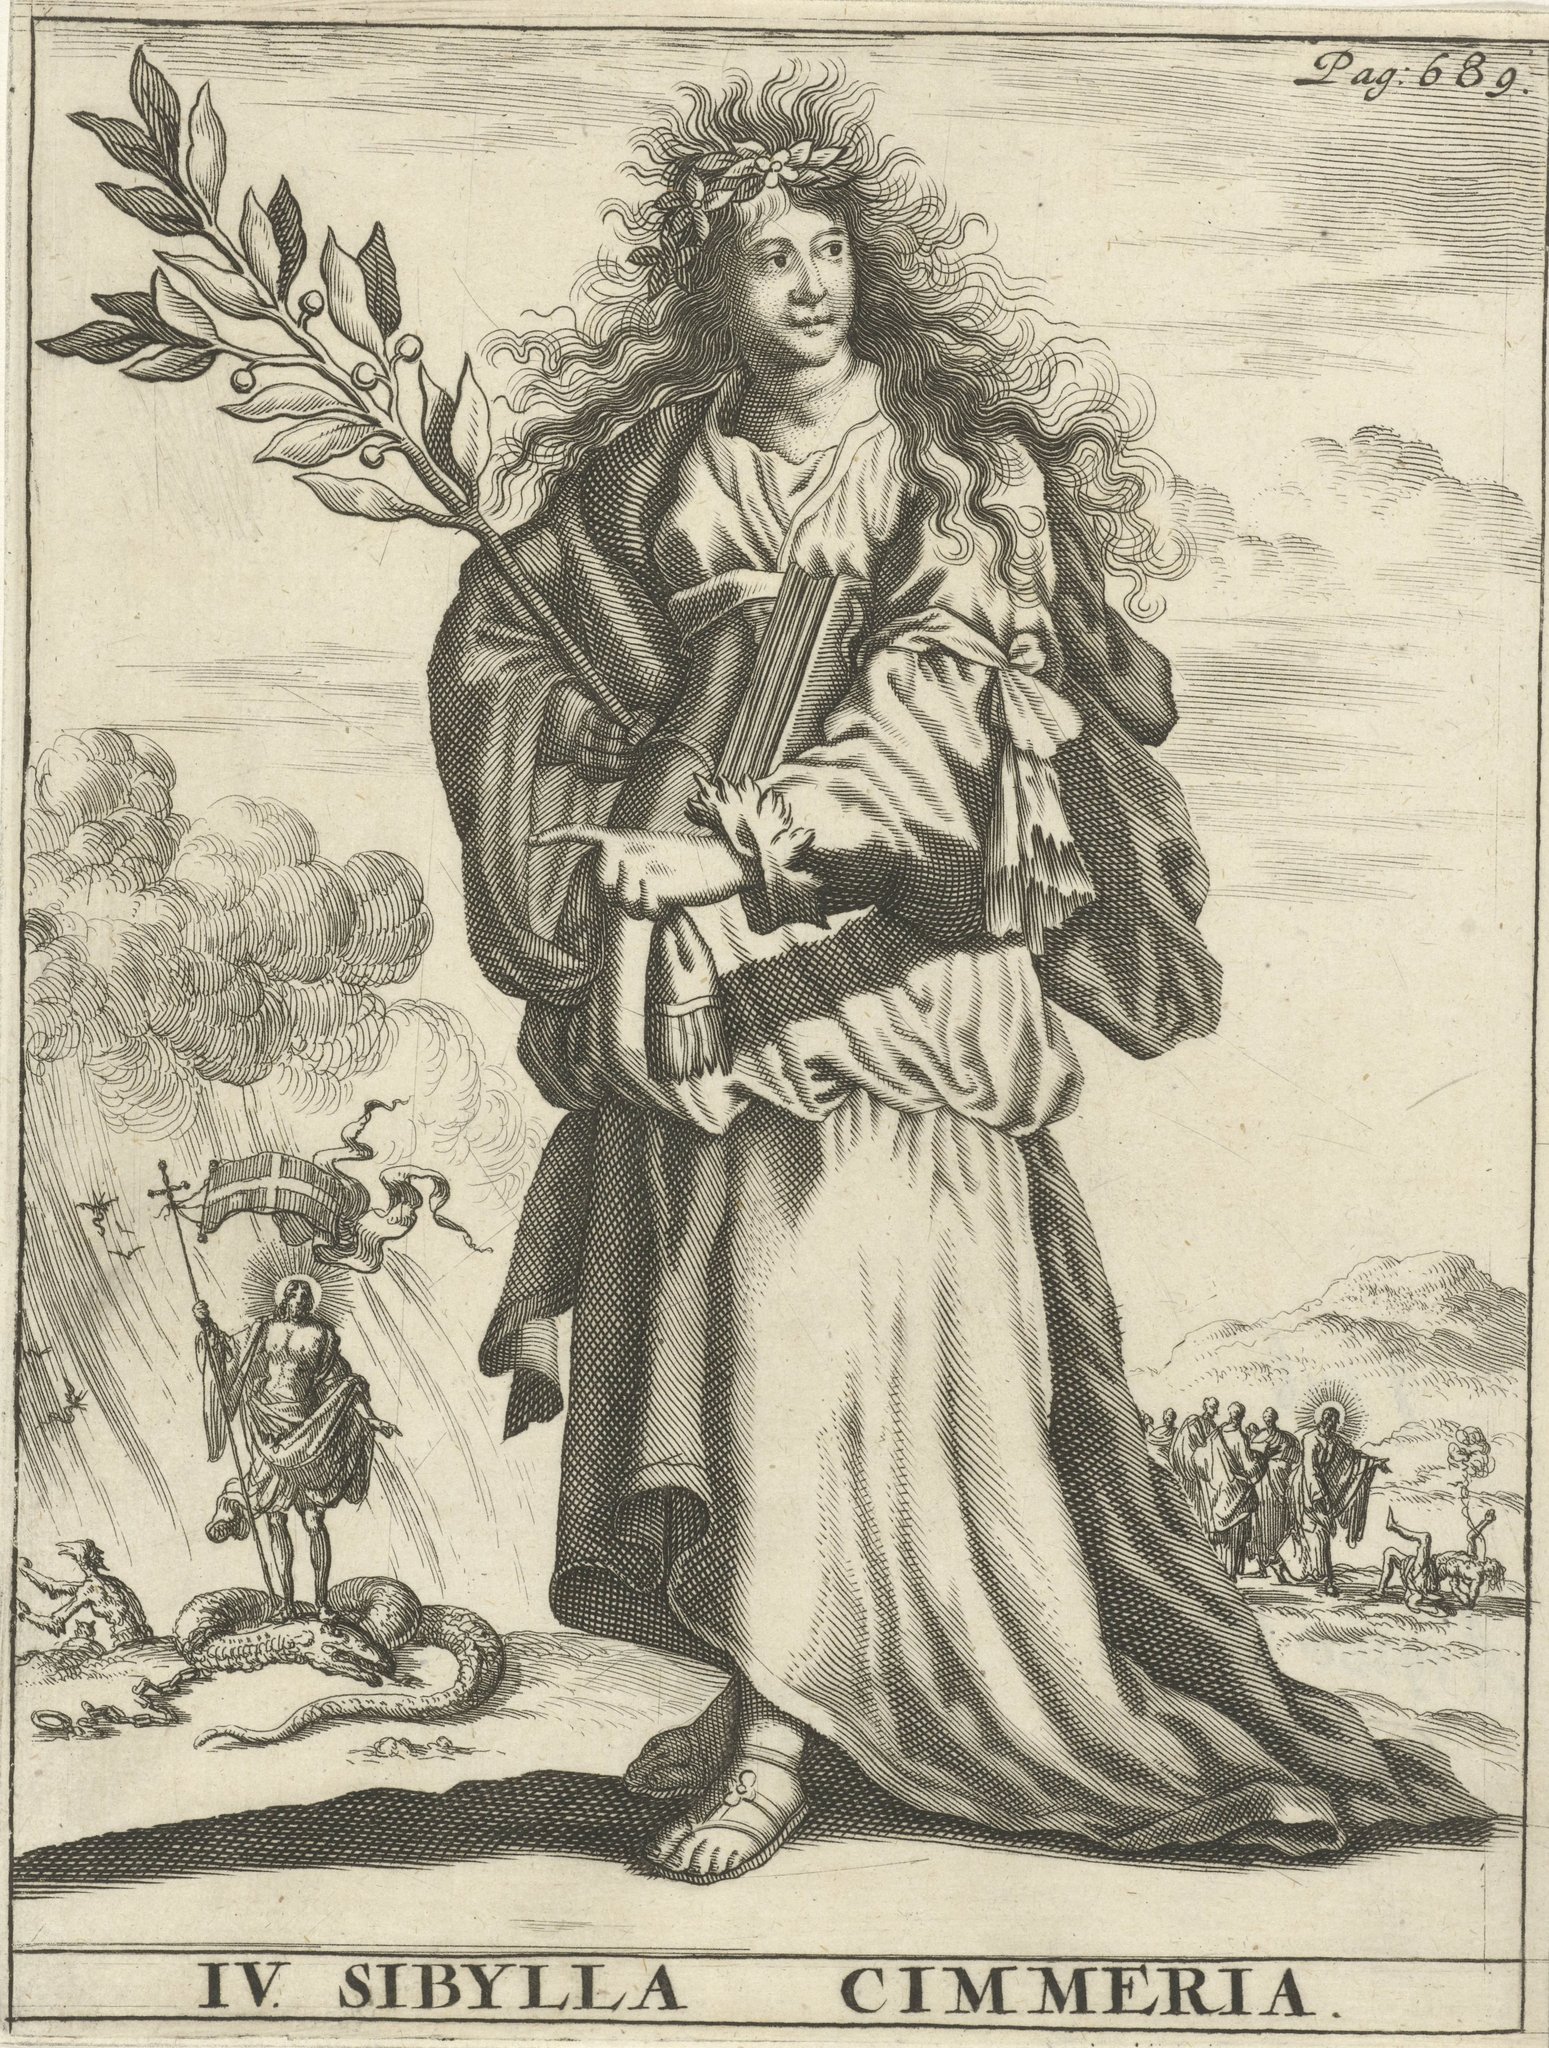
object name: print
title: Sibylla Cimmeria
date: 1684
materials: paper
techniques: engraving, etching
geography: amsterdam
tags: sibyls (with name), christ healing possessed people, christ triumphing over devil(s)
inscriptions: collector's mark: Lugt 2228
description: Cimmerische Sibille. Op de achtergrond de weergave van Christus als overwinnaar en de genezing van een bezetene. Prent rechtsboven gemerkt: Pag: 689.